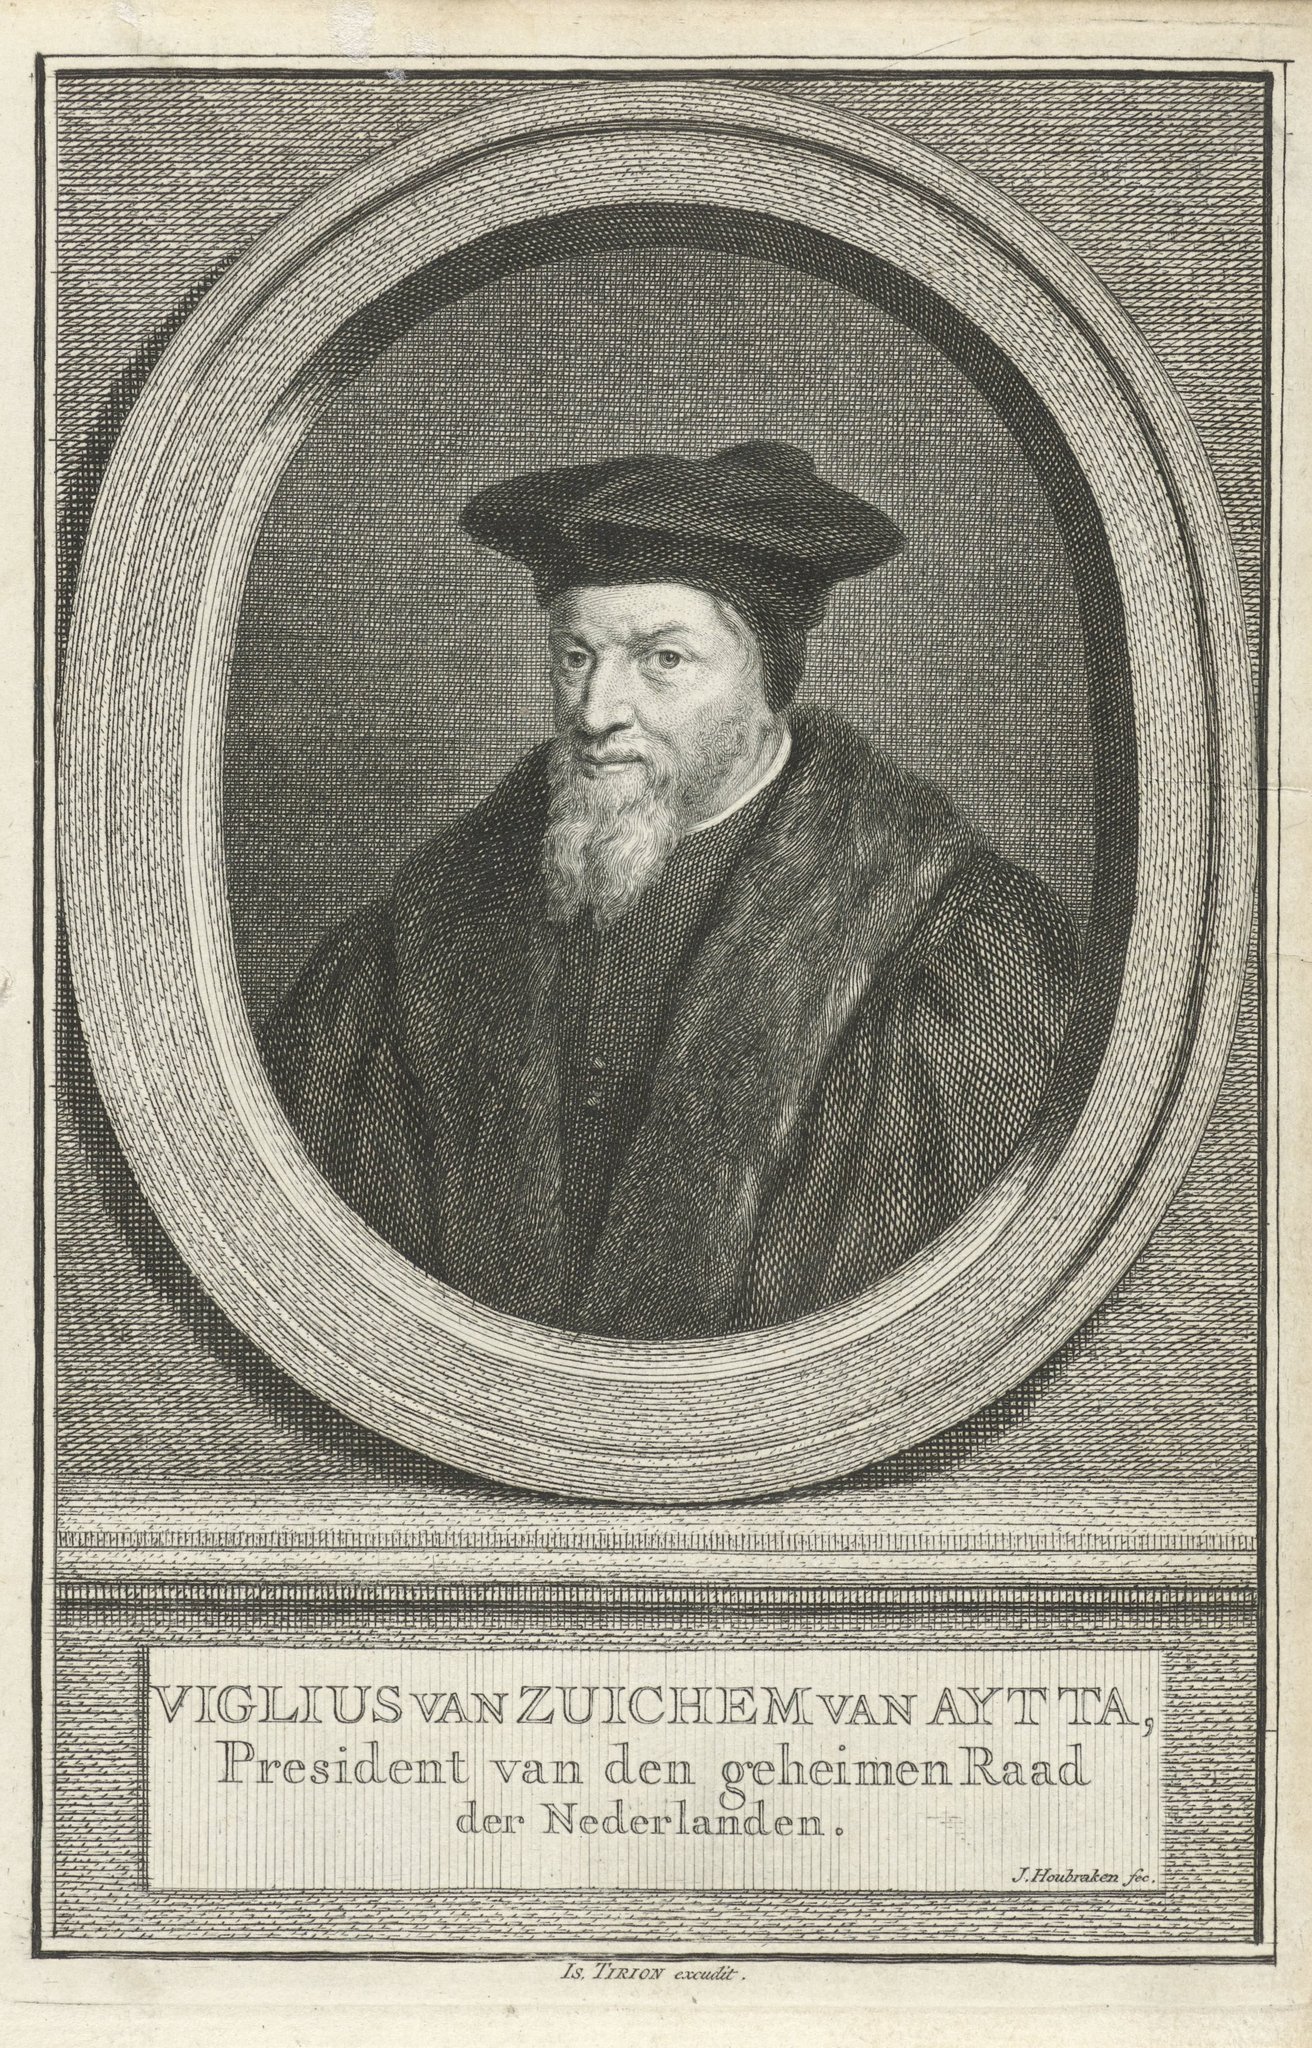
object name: print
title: Portret van Viglius ab Aytta Zuichemus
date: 1749-1759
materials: paper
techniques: engraving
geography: amsterdam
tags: brussels, clergyman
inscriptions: collector's mark: Lugt 2228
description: Prent ook gebruikt in: Jan Wagenaar, Vaderlandsche historie, vervattende de geschiedenissen der nu Vereenigde Nederlanden, inzonderheid die van Holland (...), 21 delen. Amsterdam, Isaak Tirion, 1749-59.